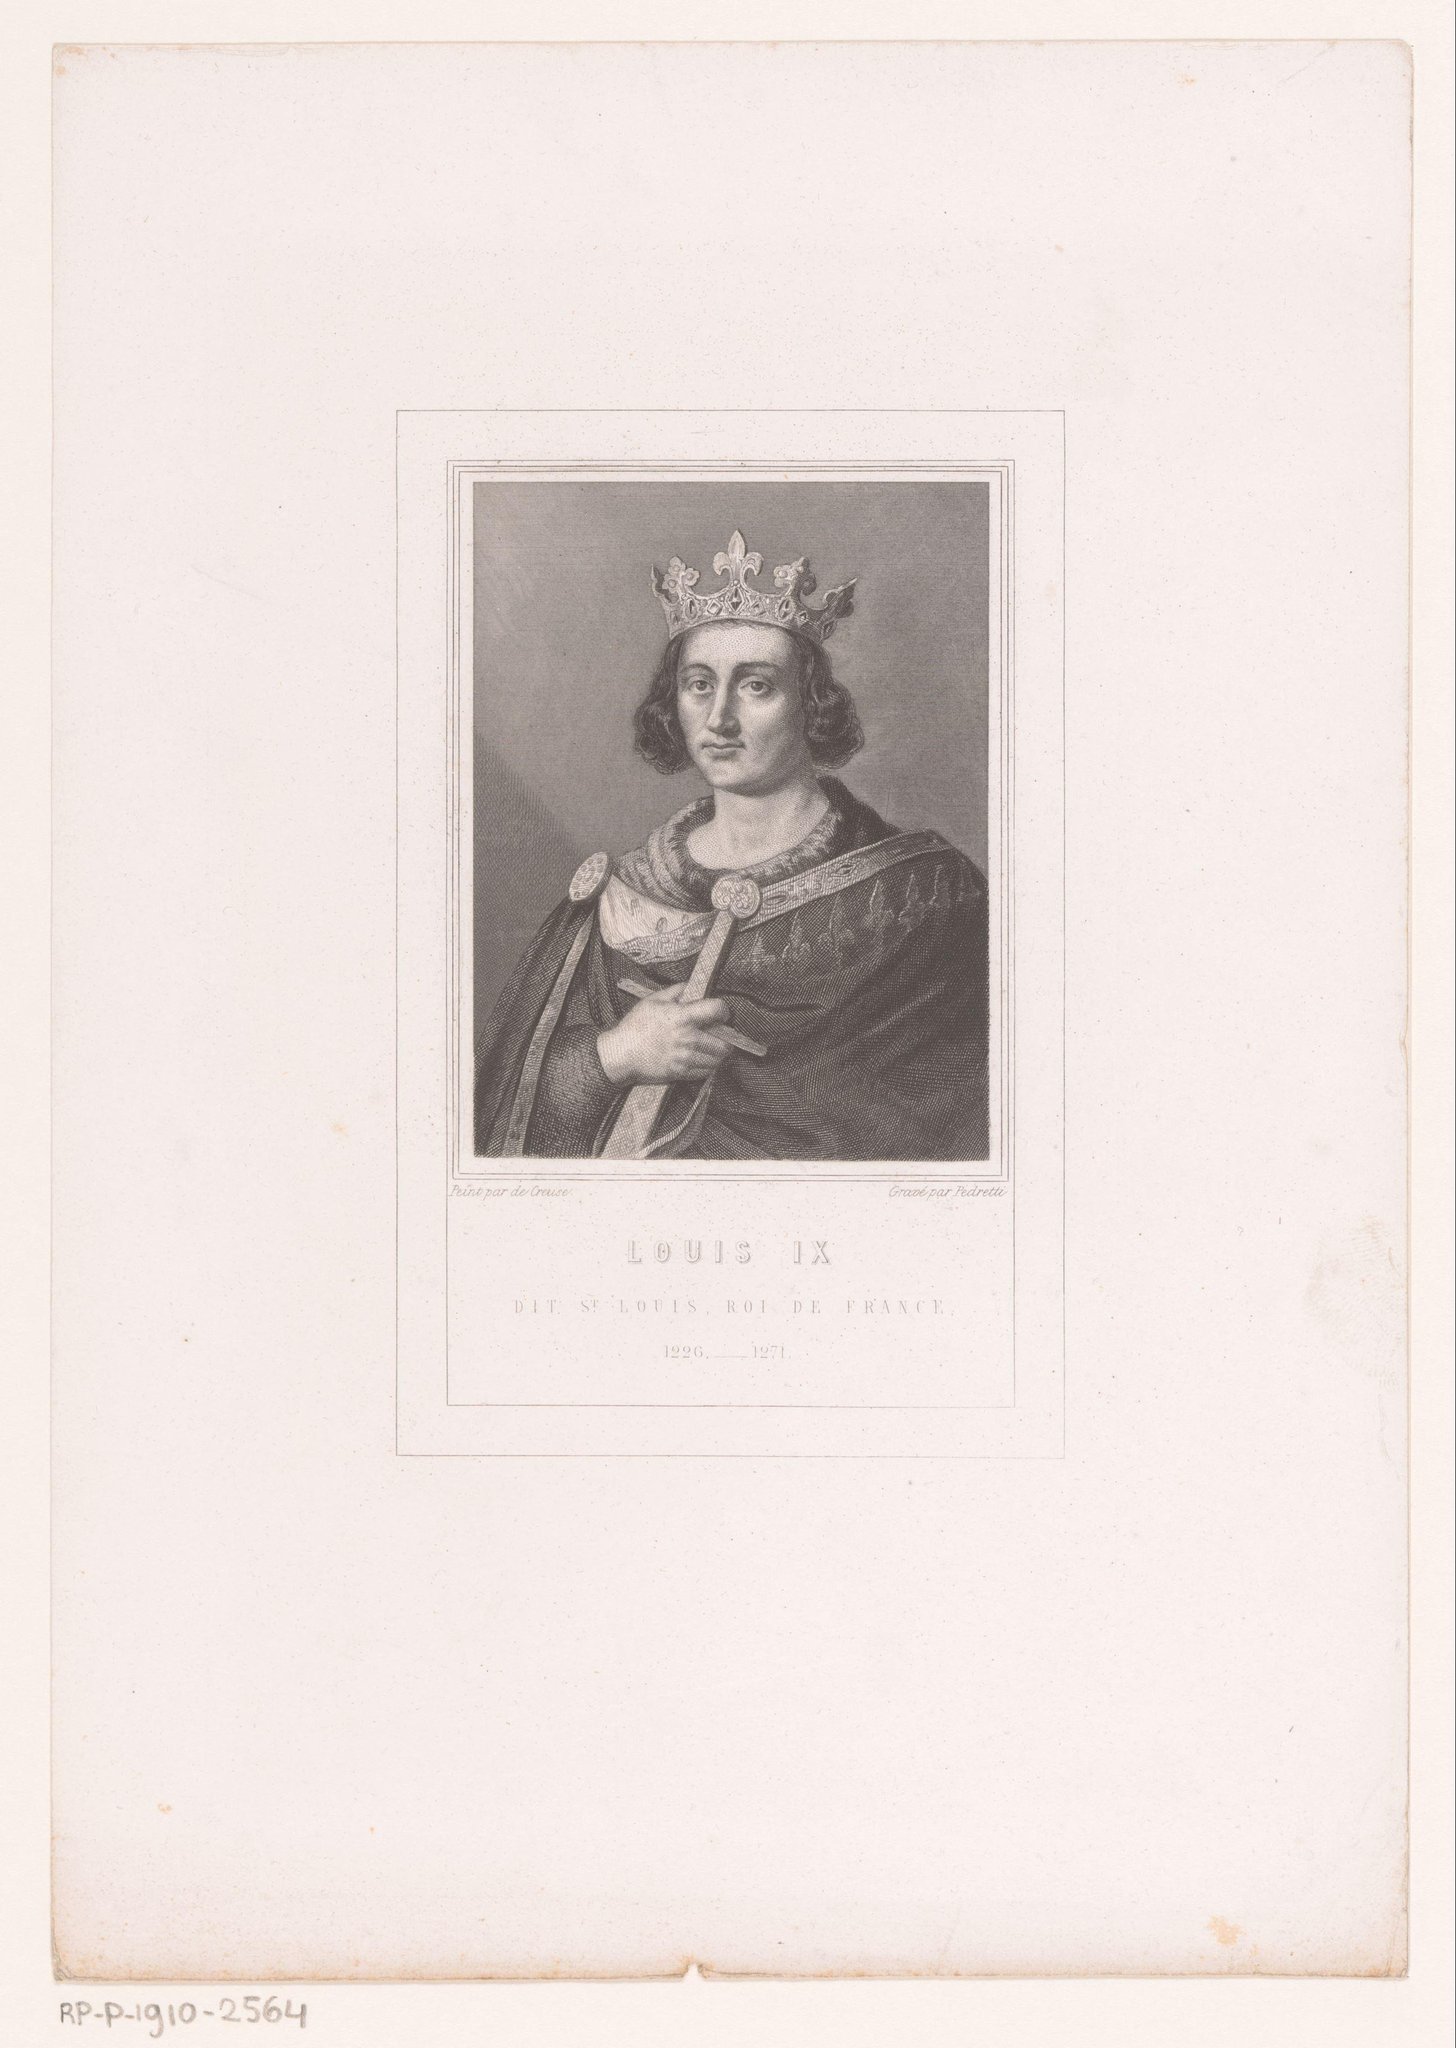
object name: print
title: Portret van Lodewijk IX de Heilige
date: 1815-1868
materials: paper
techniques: engraving, etching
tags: historical persons, king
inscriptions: collector's mark: Lugt 2228